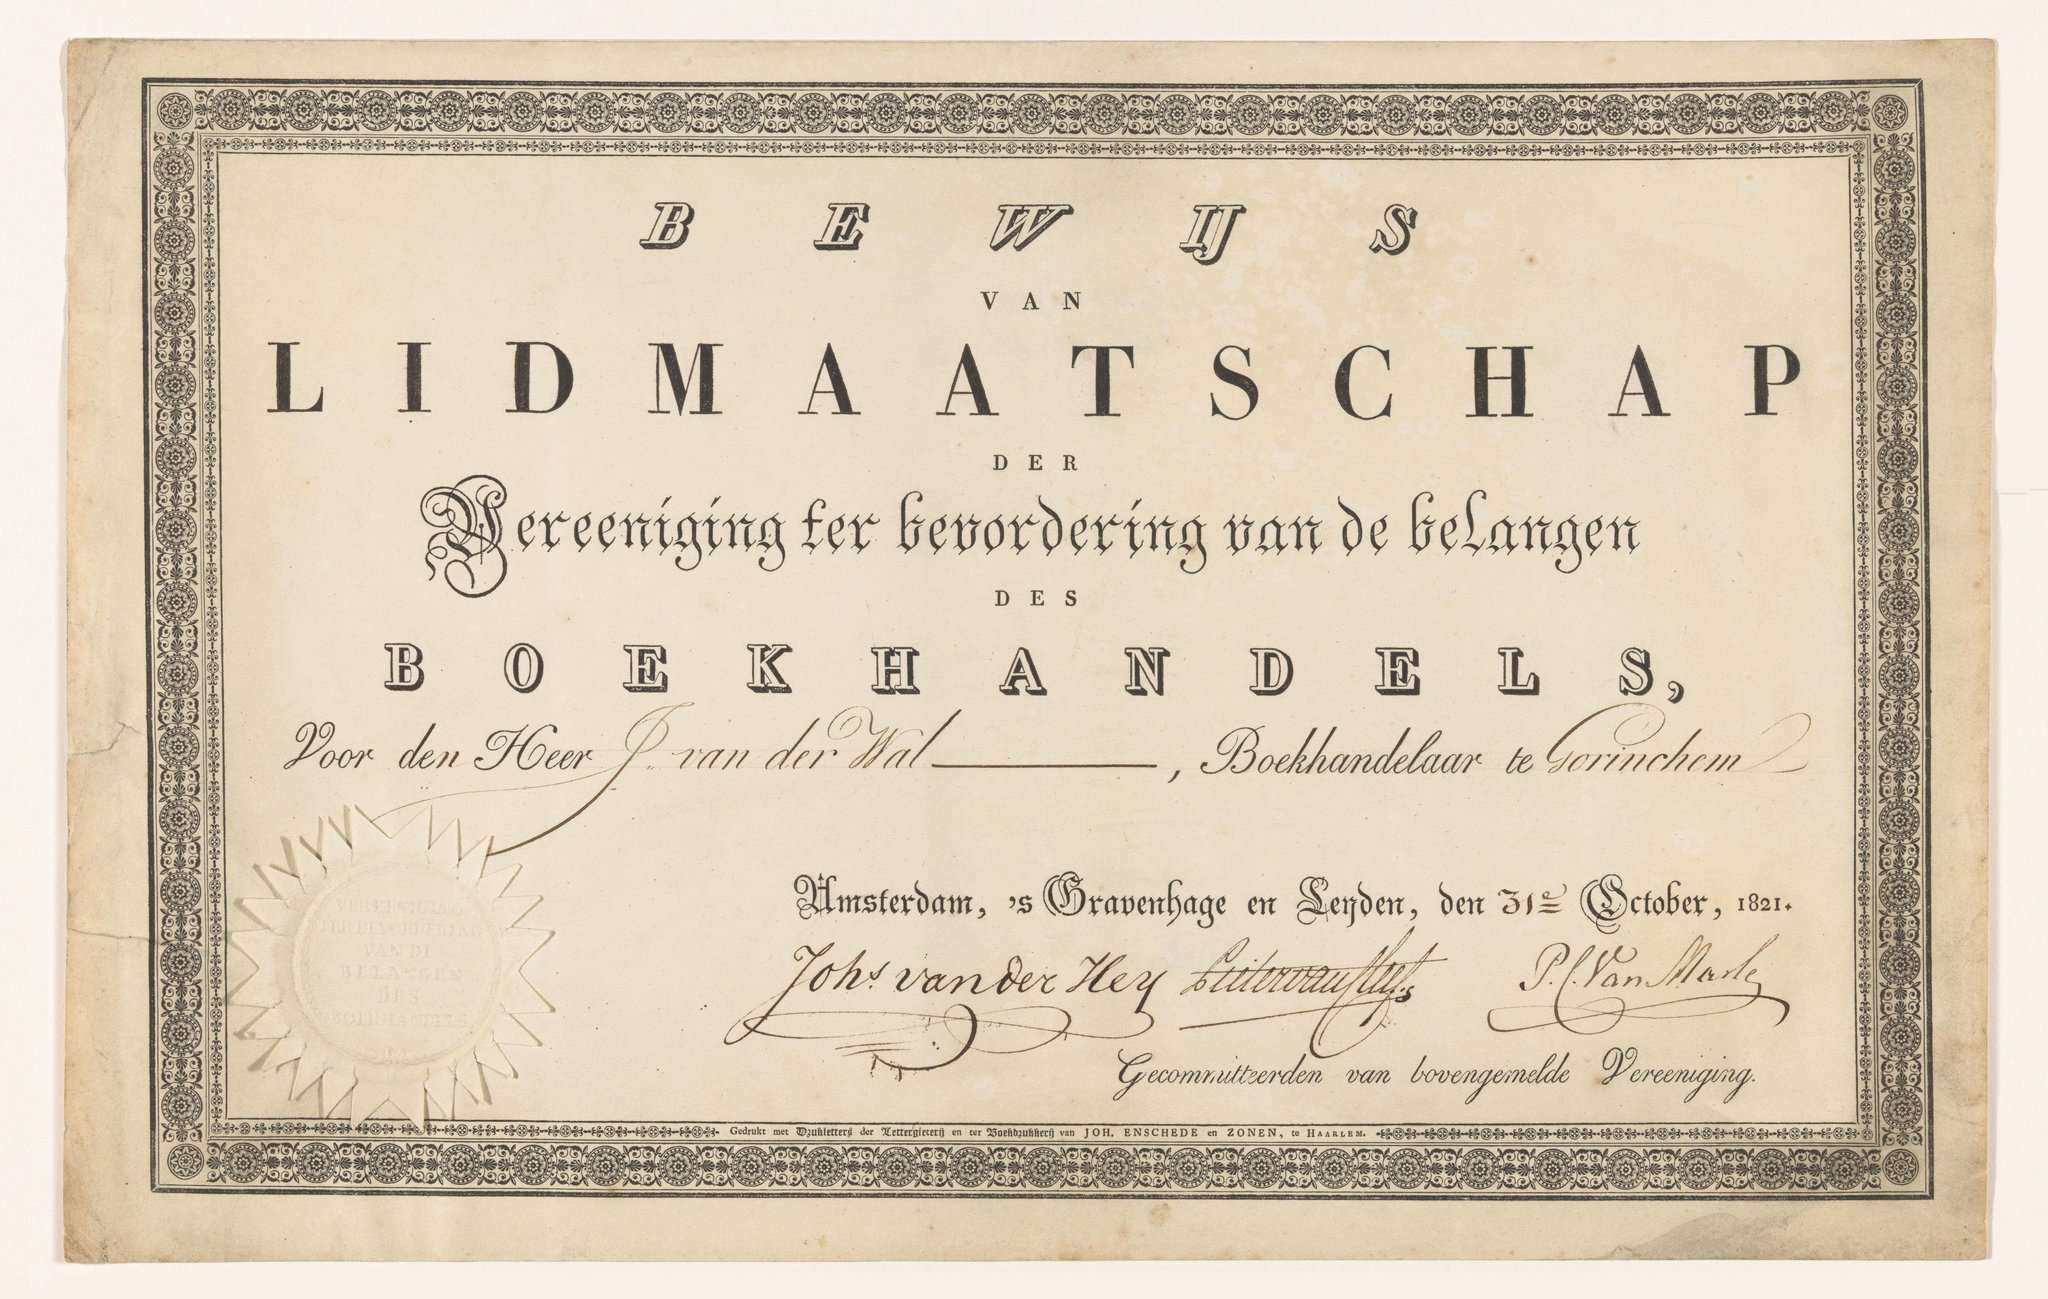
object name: charter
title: Bewijs van lidmaatschap van de Vereeniging ter bevordering van de belangen des boekhandels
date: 1821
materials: ink, paper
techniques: letterpress printing, pen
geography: haarlem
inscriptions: annotation: ‘veiling bss [?] Dec. 1946’, collector's mark: Lugt 2228, collector's mark: Lugt 4779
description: Uitgereikt aan J. van der Wal, boekhandelaar te Gorinchem, op 31 oktober 1821. Ondertekend door Johannes van der Hey, Pieter van Cleef en P.C. van Marle en met blindstempel van de Vereeniging ter bevordering van de belangen des boekhandels.